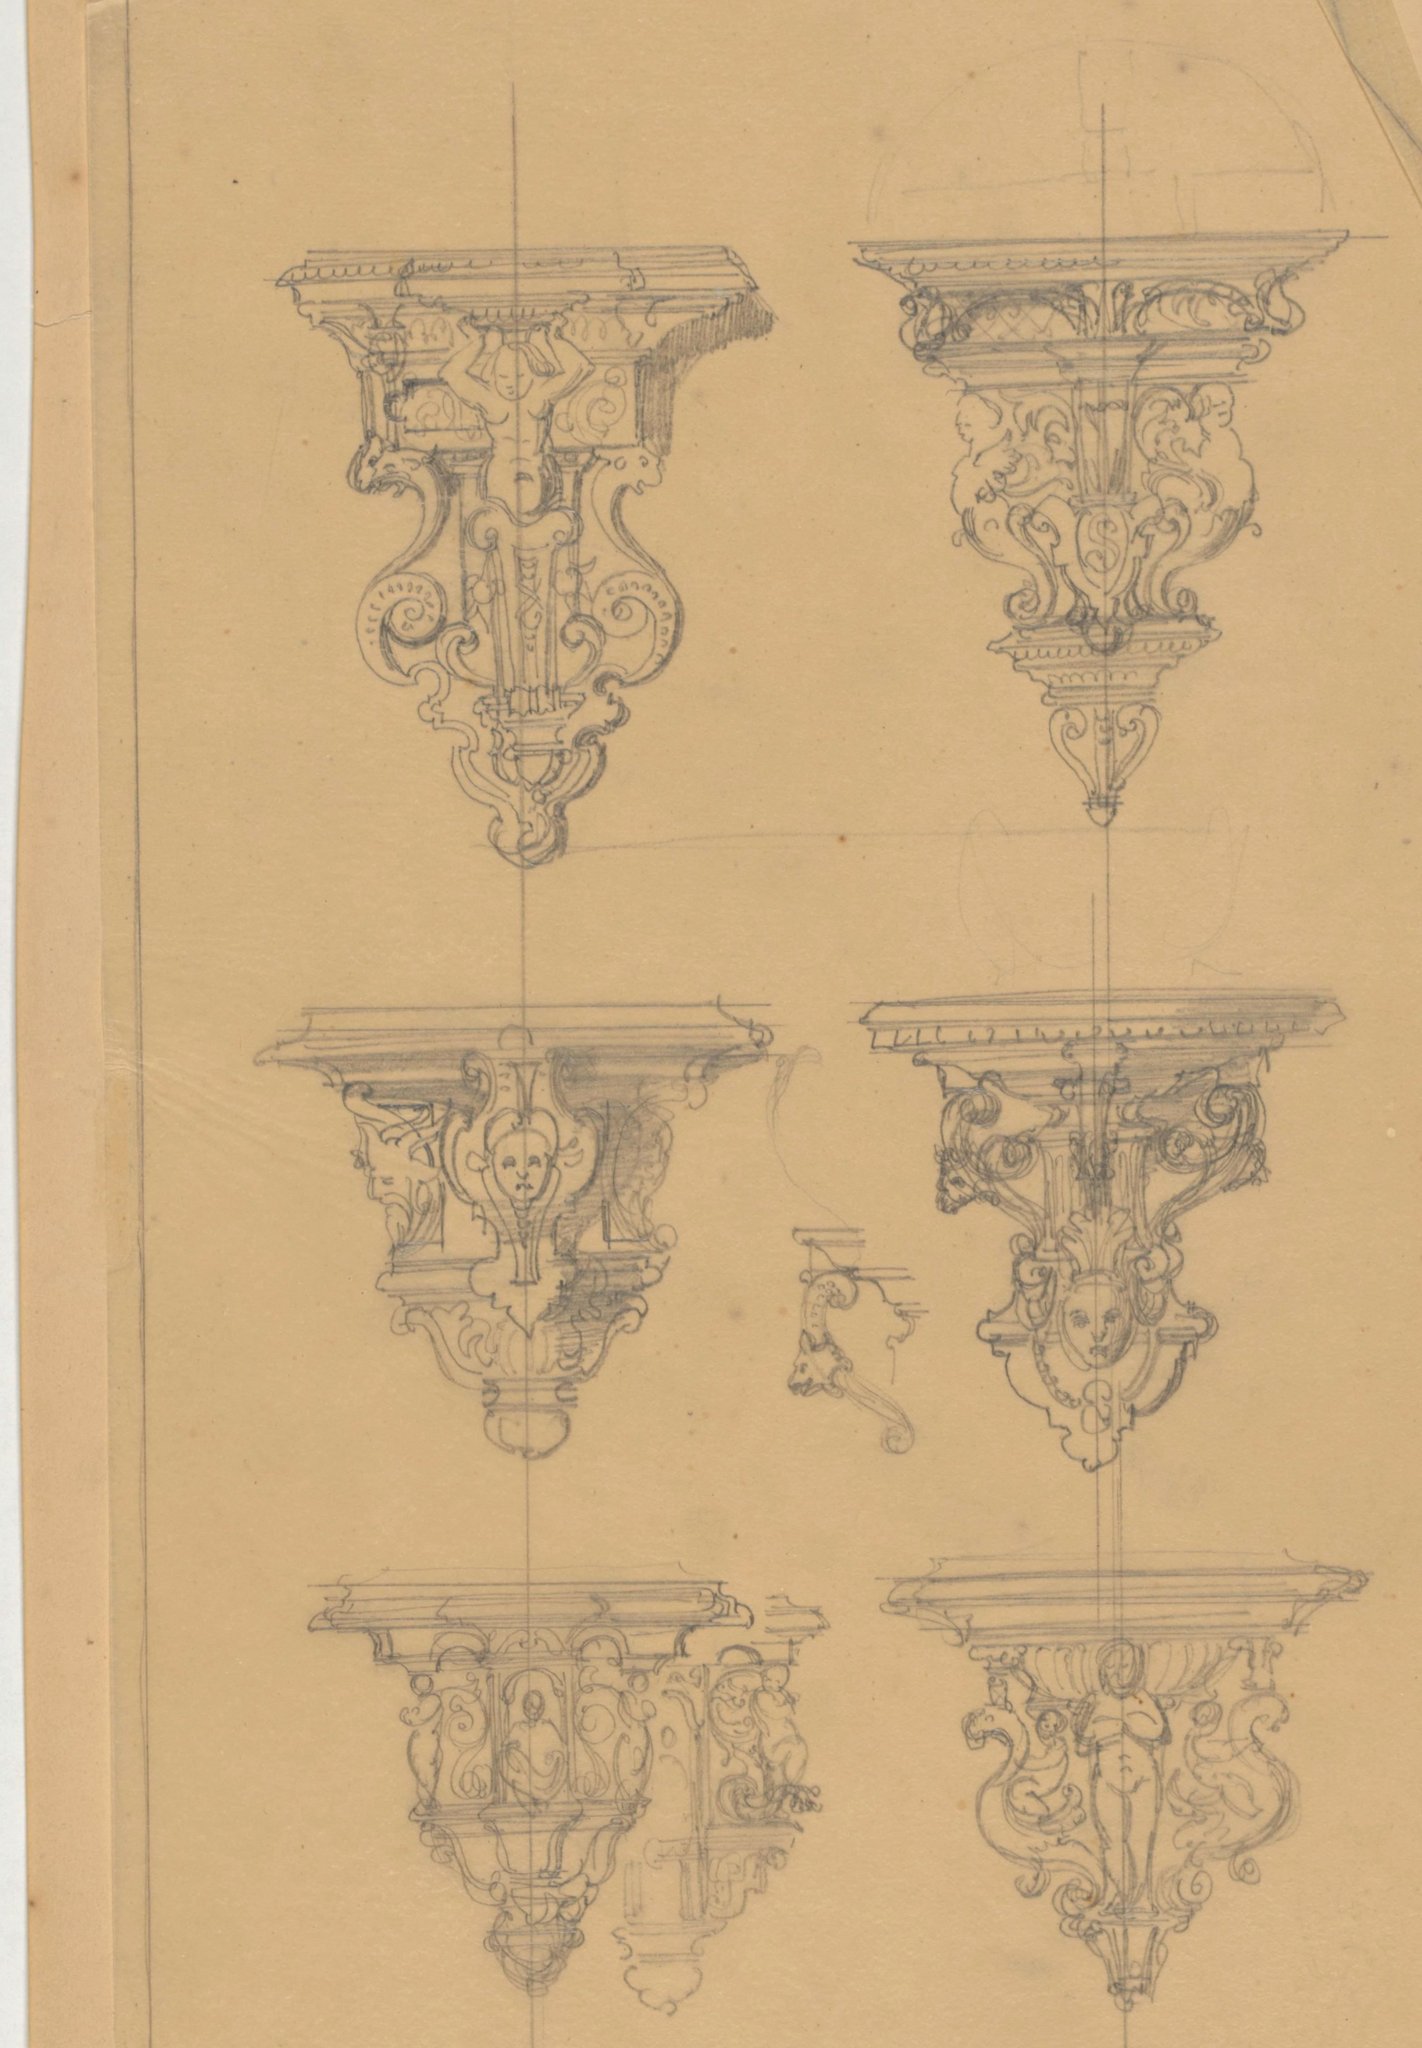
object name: design drawing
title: Acht consoles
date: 1830-1850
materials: graphite, paper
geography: paris